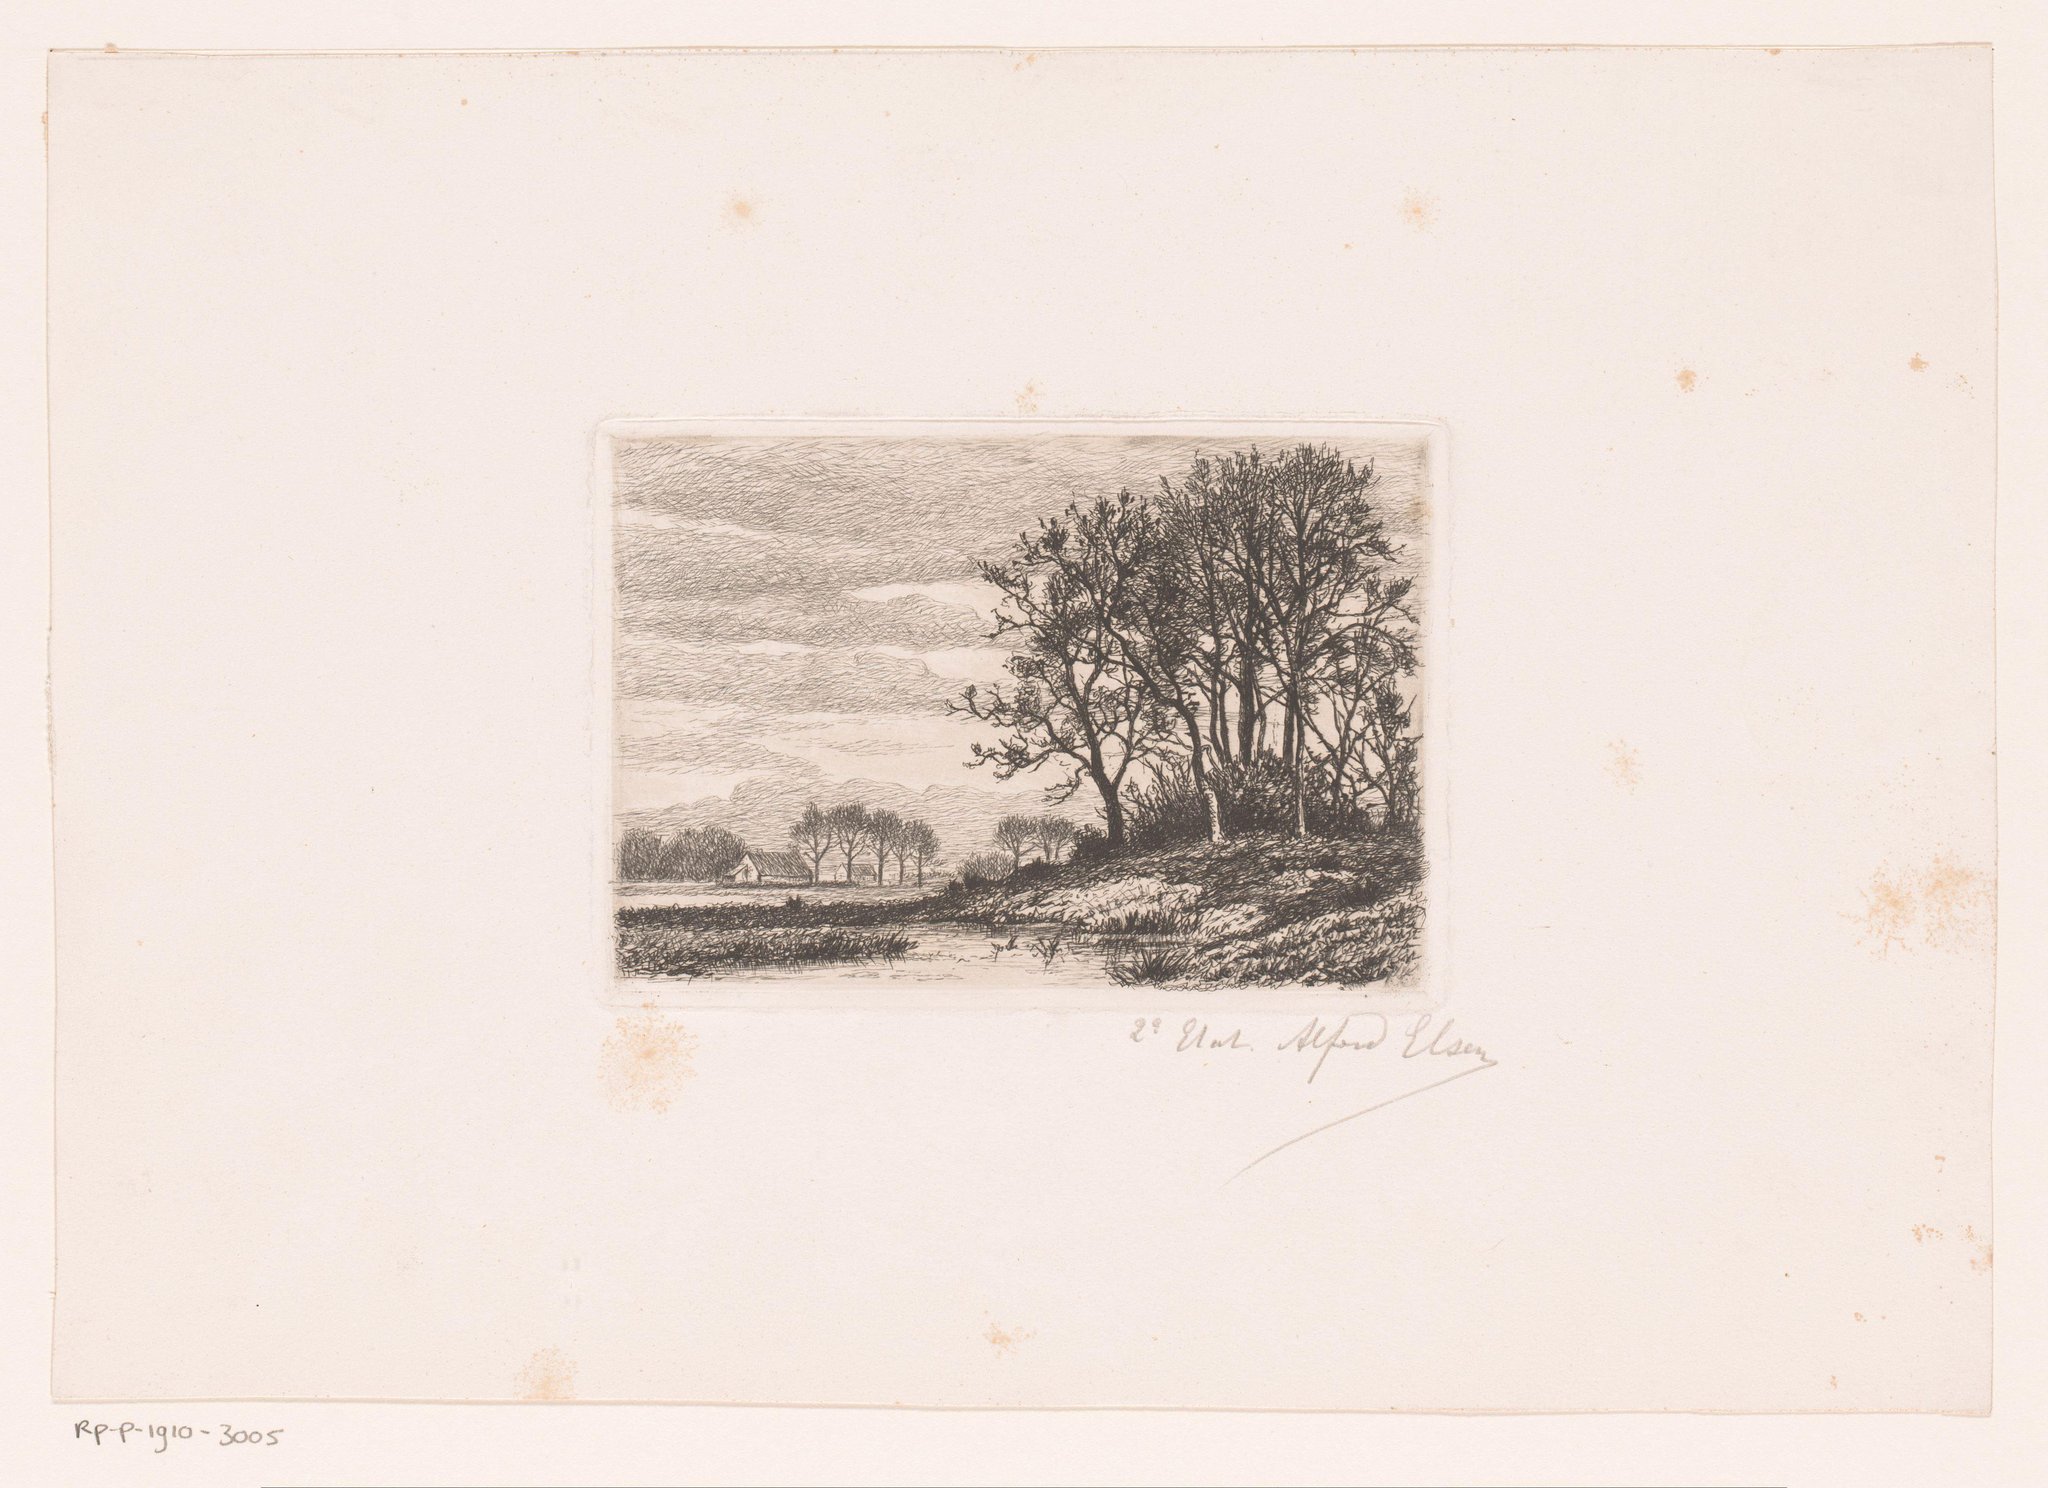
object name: print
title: Landschap met bomen op een heuvel aan het water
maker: alfred elsen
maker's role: painter, print maker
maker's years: 1850-1914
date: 1860-1910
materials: paper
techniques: etching, intaglio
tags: low hill country, landscapes with waters, waterscapes, seascapes (in the temperate zone), farm or solitary house in landscape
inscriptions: collector's mark: Lugt 2228, inscription: ‘2e Etat’